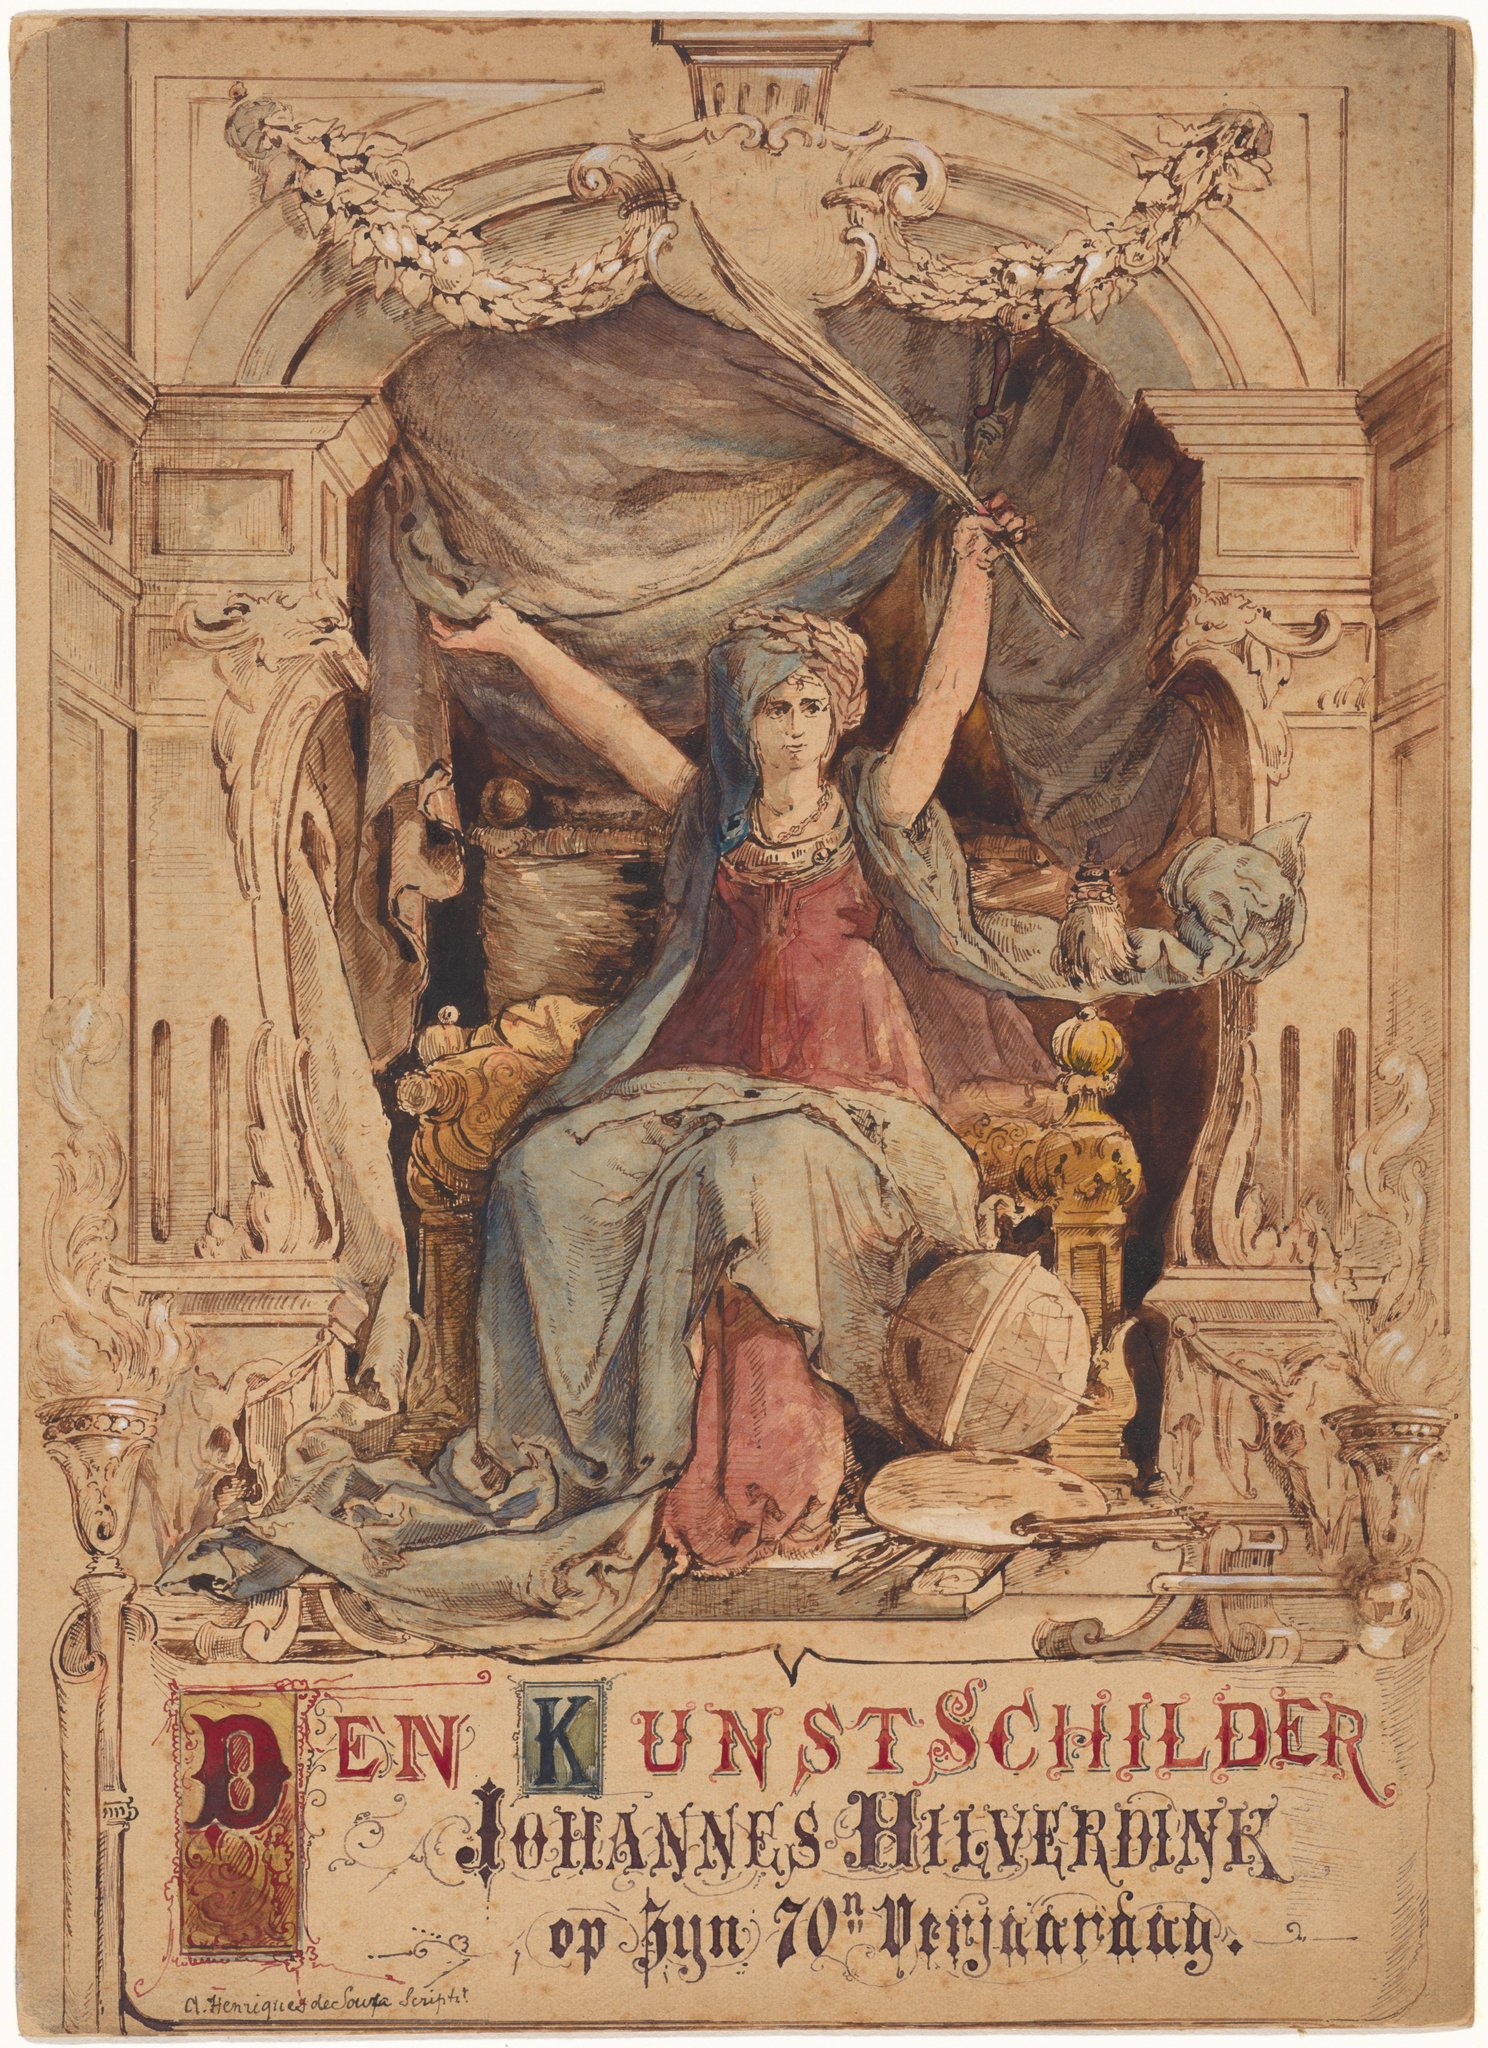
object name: watercolor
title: Personificatie van de schilderkunst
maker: abraham henriques de souza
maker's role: draughtsman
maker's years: 1846-1912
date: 1856-1912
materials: ink, paper, pencil, watercolor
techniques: brush, pen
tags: art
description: Personificatie van de schilderkunst ter ere van de kunstschilder Johannes Hilverdink op zijn 70ste verjaardag.